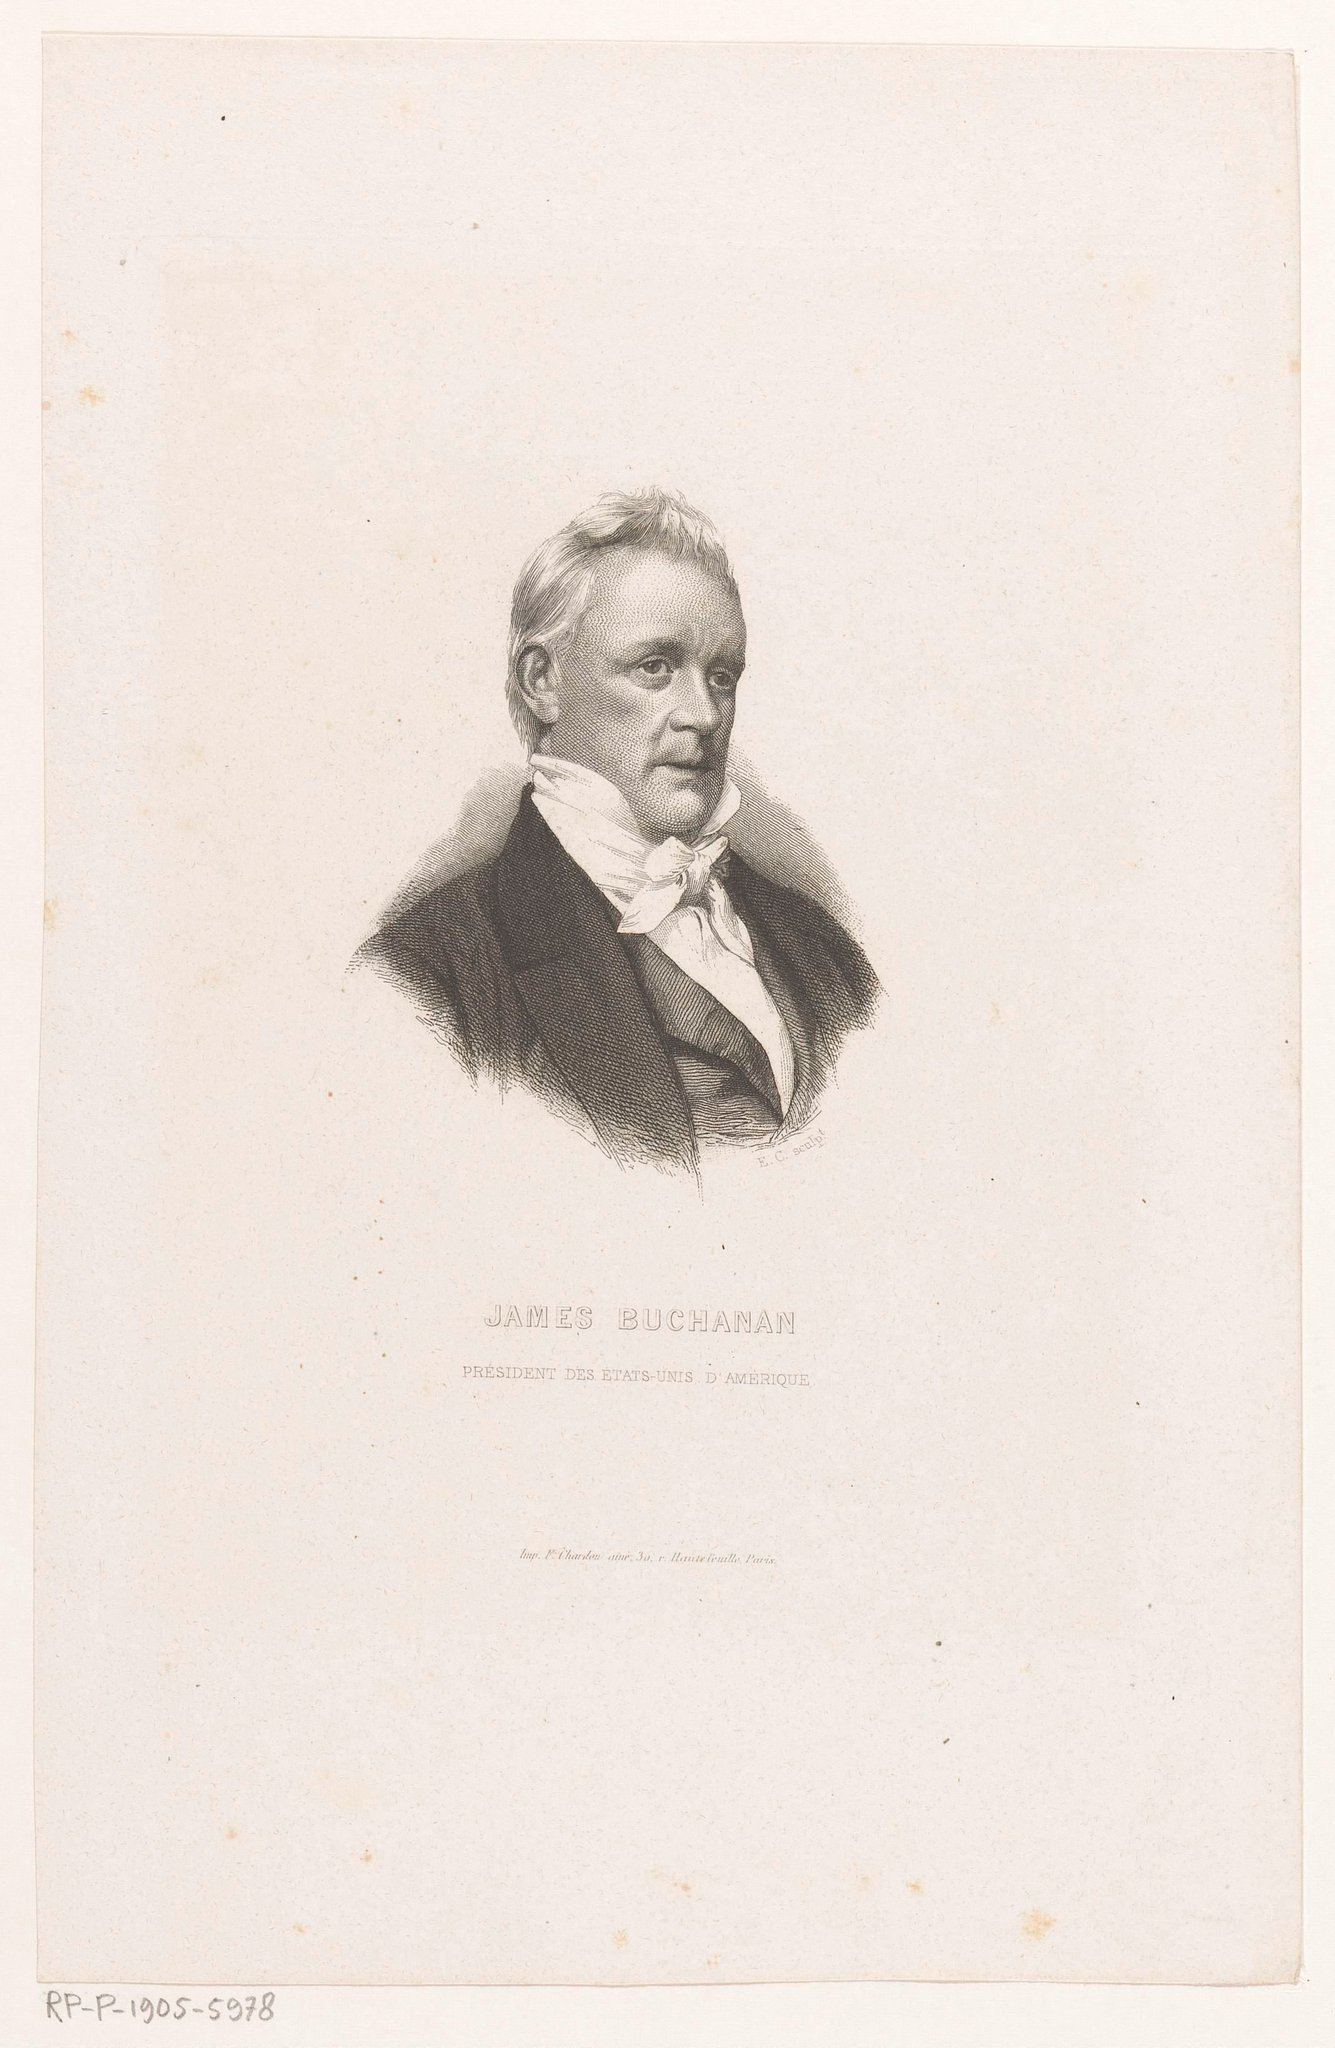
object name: print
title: James Buchanan Président des Etats-Unis d'Amérique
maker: pierre jean edmond castan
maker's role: print maker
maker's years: 1817-1892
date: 1827-1892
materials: paper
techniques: engraving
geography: france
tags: president ~ head of republic, historical persons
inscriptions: collector's mark: Lugt 2228